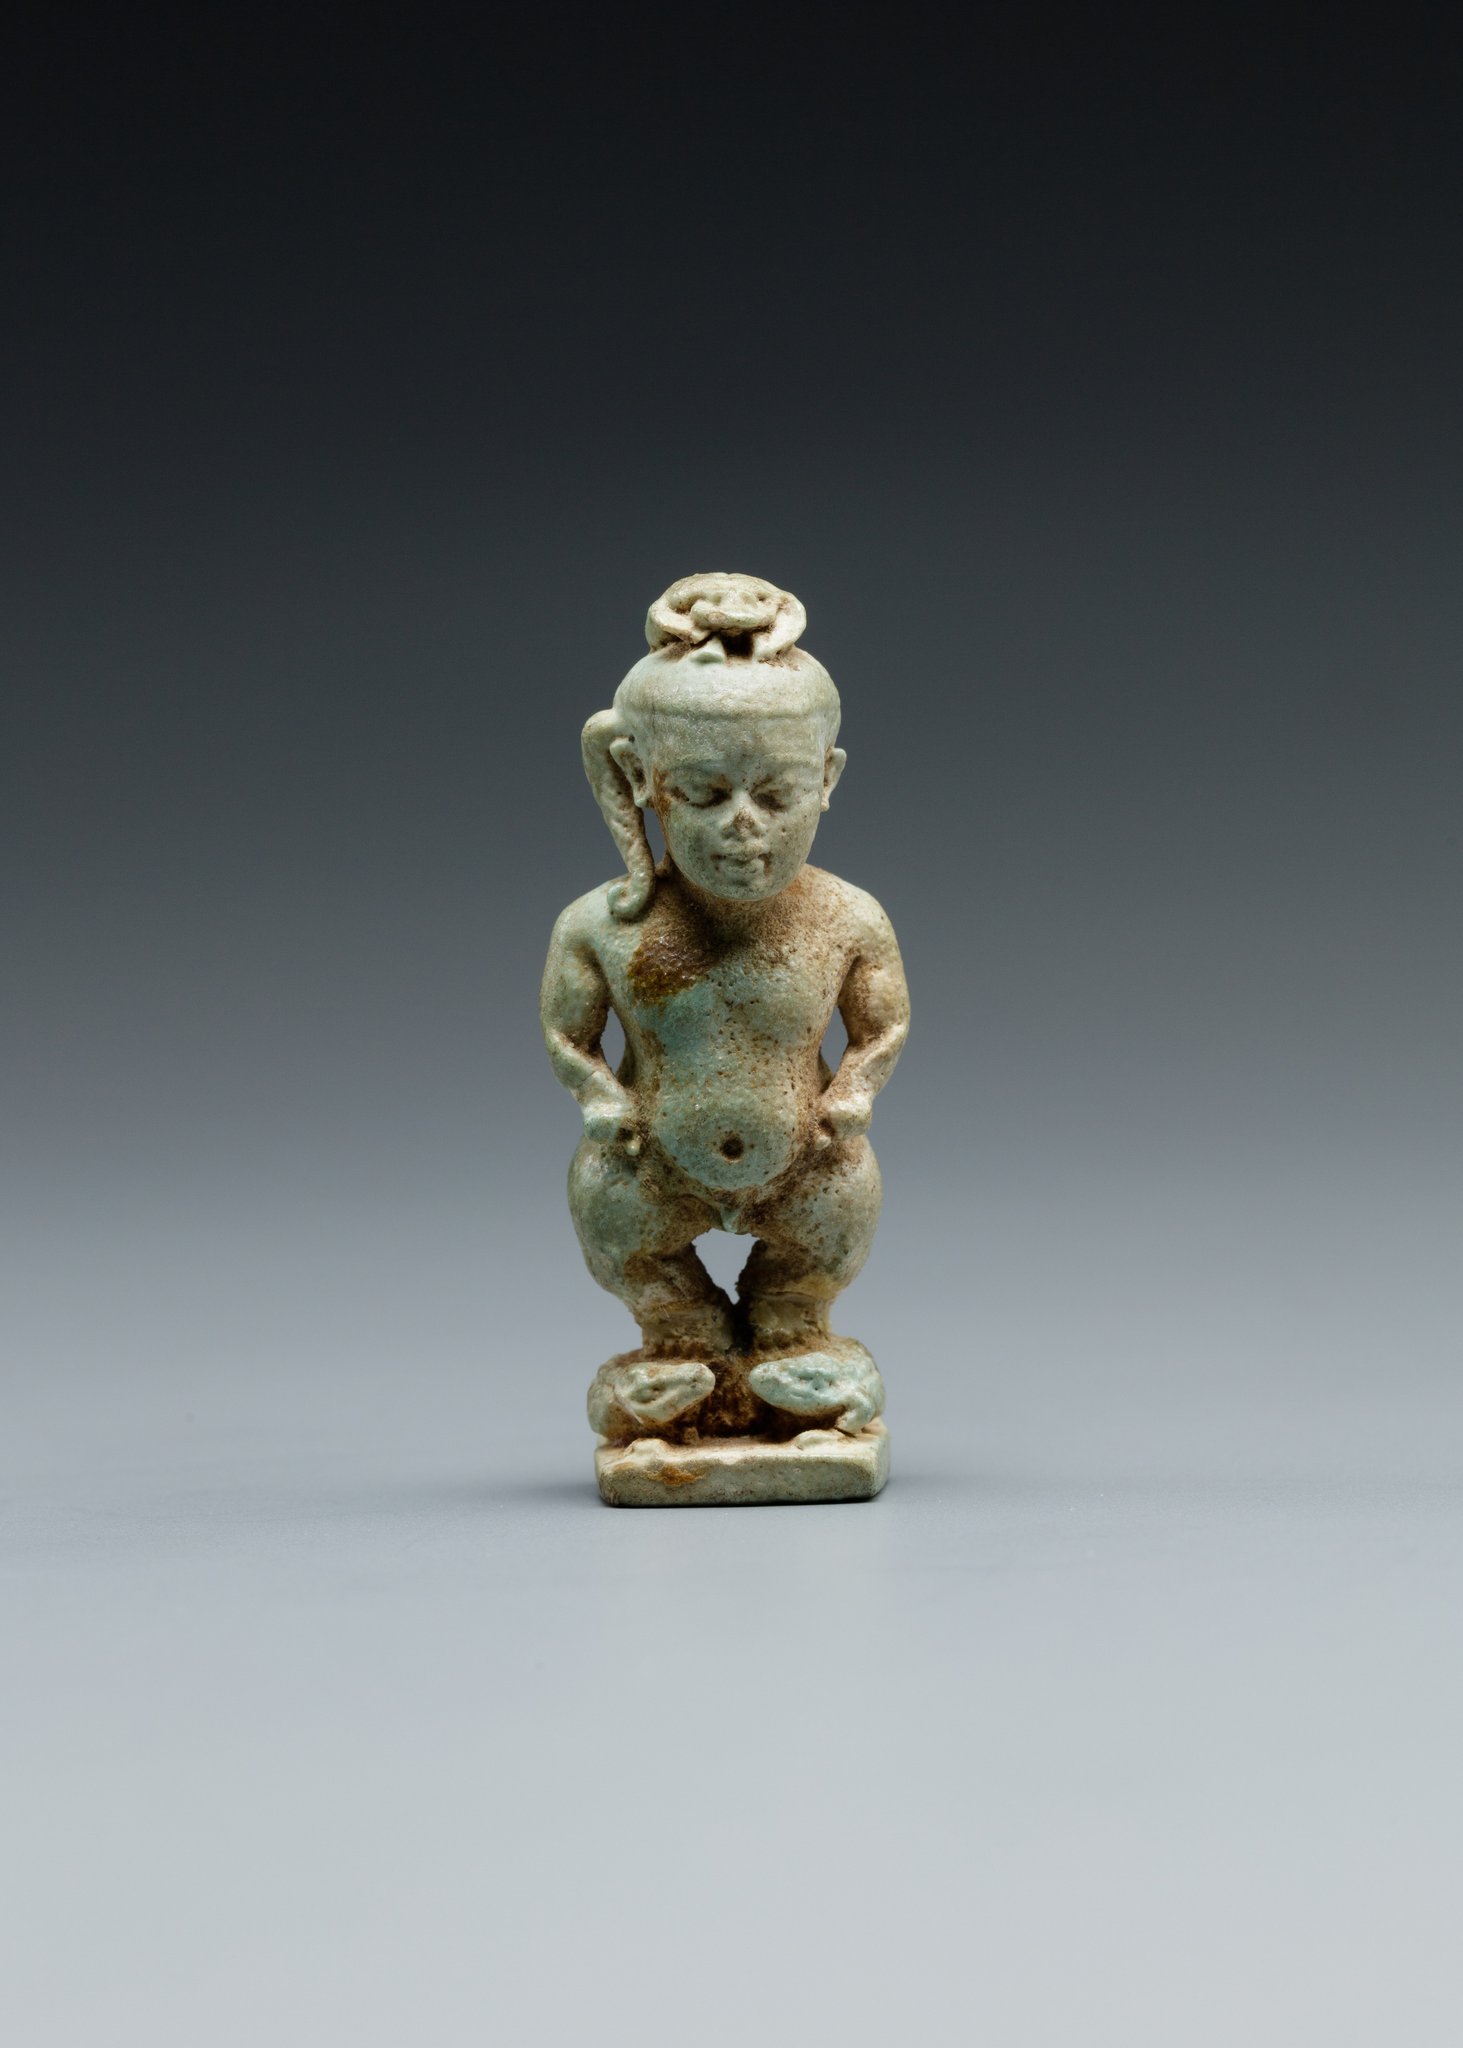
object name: amulet, pataikos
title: Amulet: Pataikos astride crocodiles and with a scarab on his head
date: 664-332 BCE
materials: faience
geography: egypt